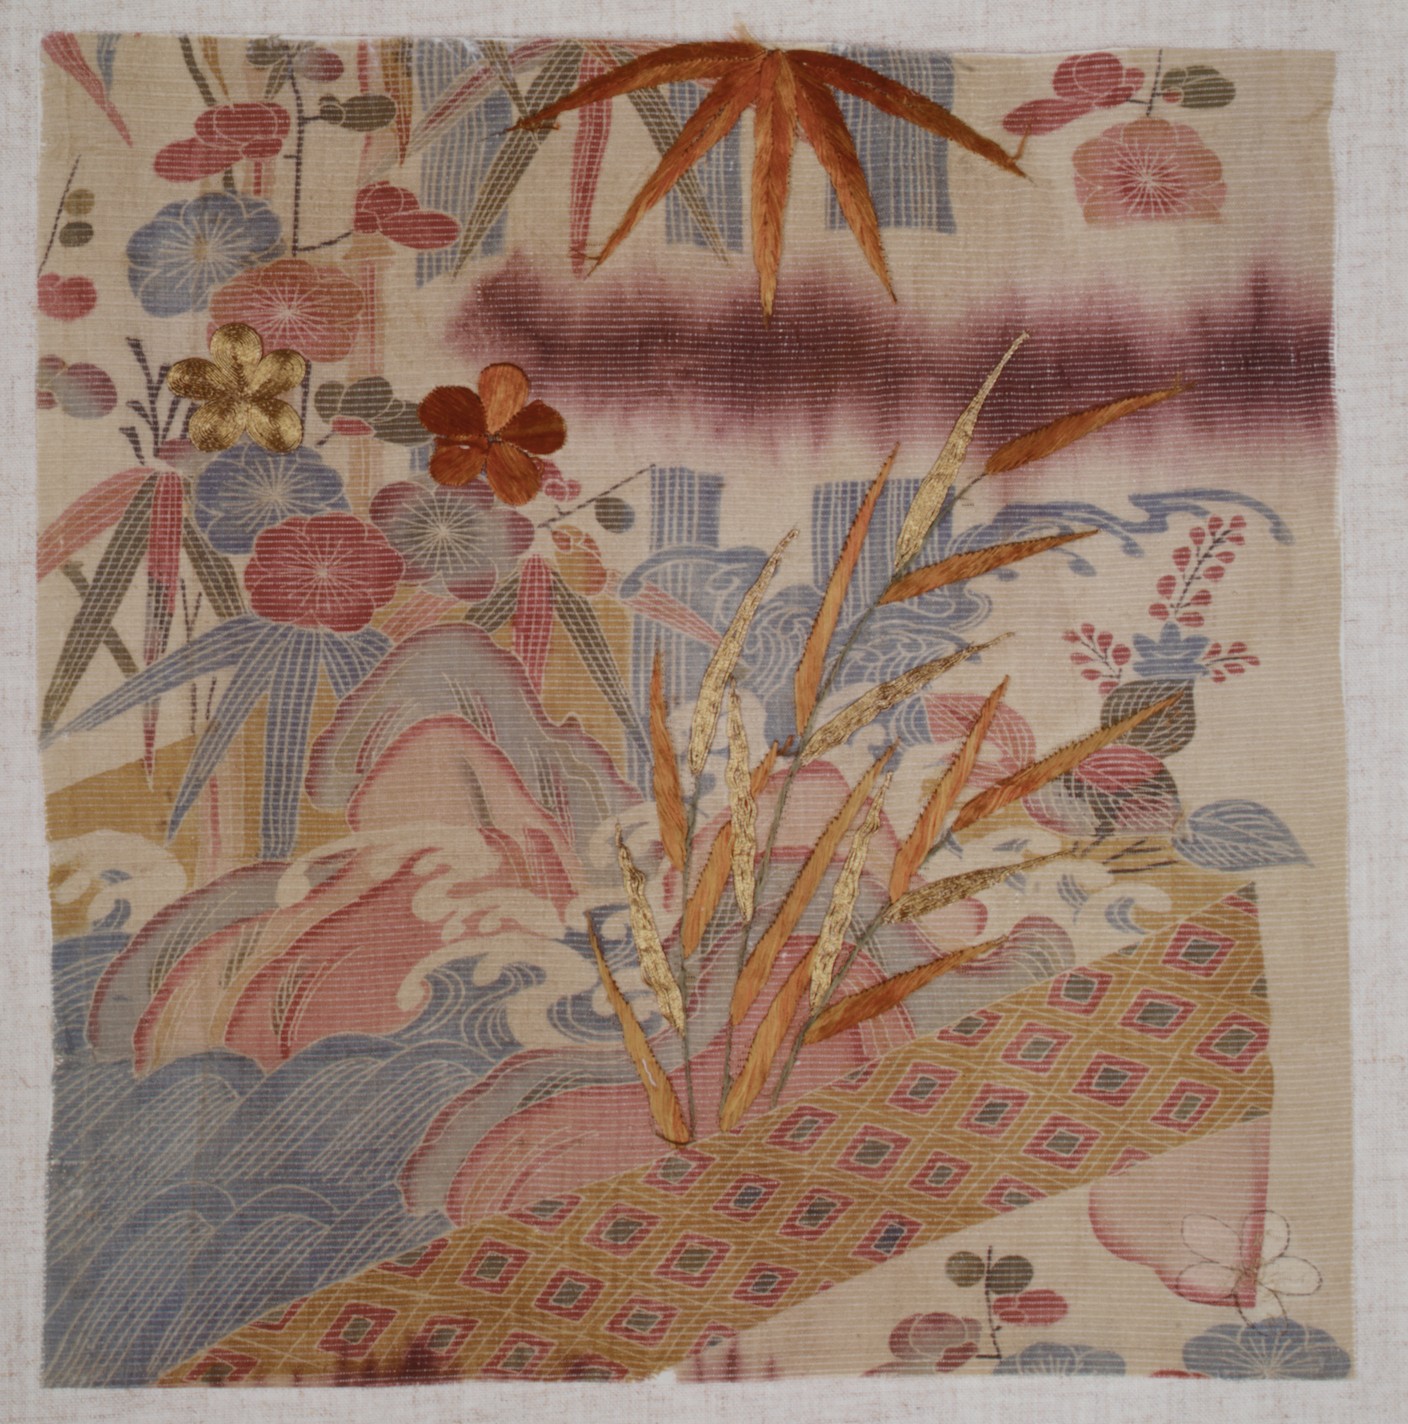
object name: piece from an unlined robe hitoe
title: Fragment of an Unlined Kosode (Hitoe)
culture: japanese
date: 1701-1800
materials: dye, textile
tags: leaves